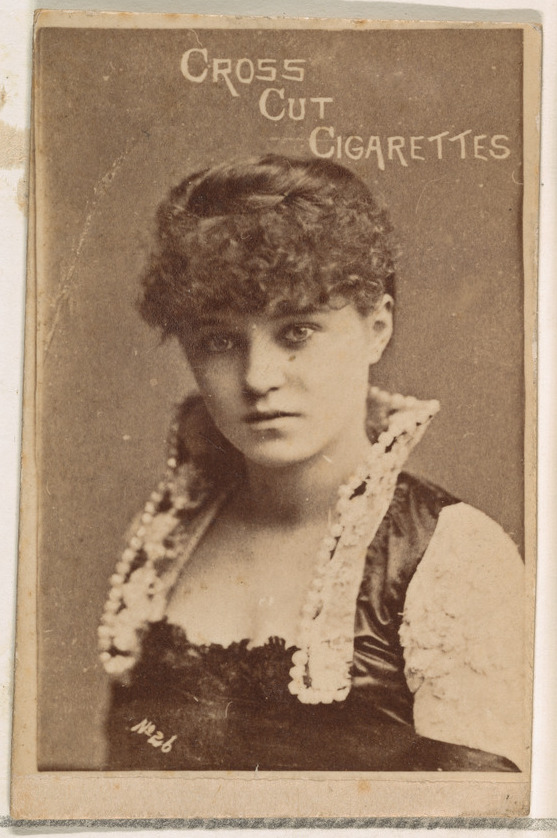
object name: print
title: Card Number 26, from the Actors and Actresses series (N145-1) issued by Duke Sons & Co. to promote Cross Cut Cigarettes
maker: w. duke, sons & co.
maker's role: publisher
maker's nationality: american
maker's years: 1870-1920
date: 1880-1889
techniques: albumen silver print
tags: portraits,women,actresses